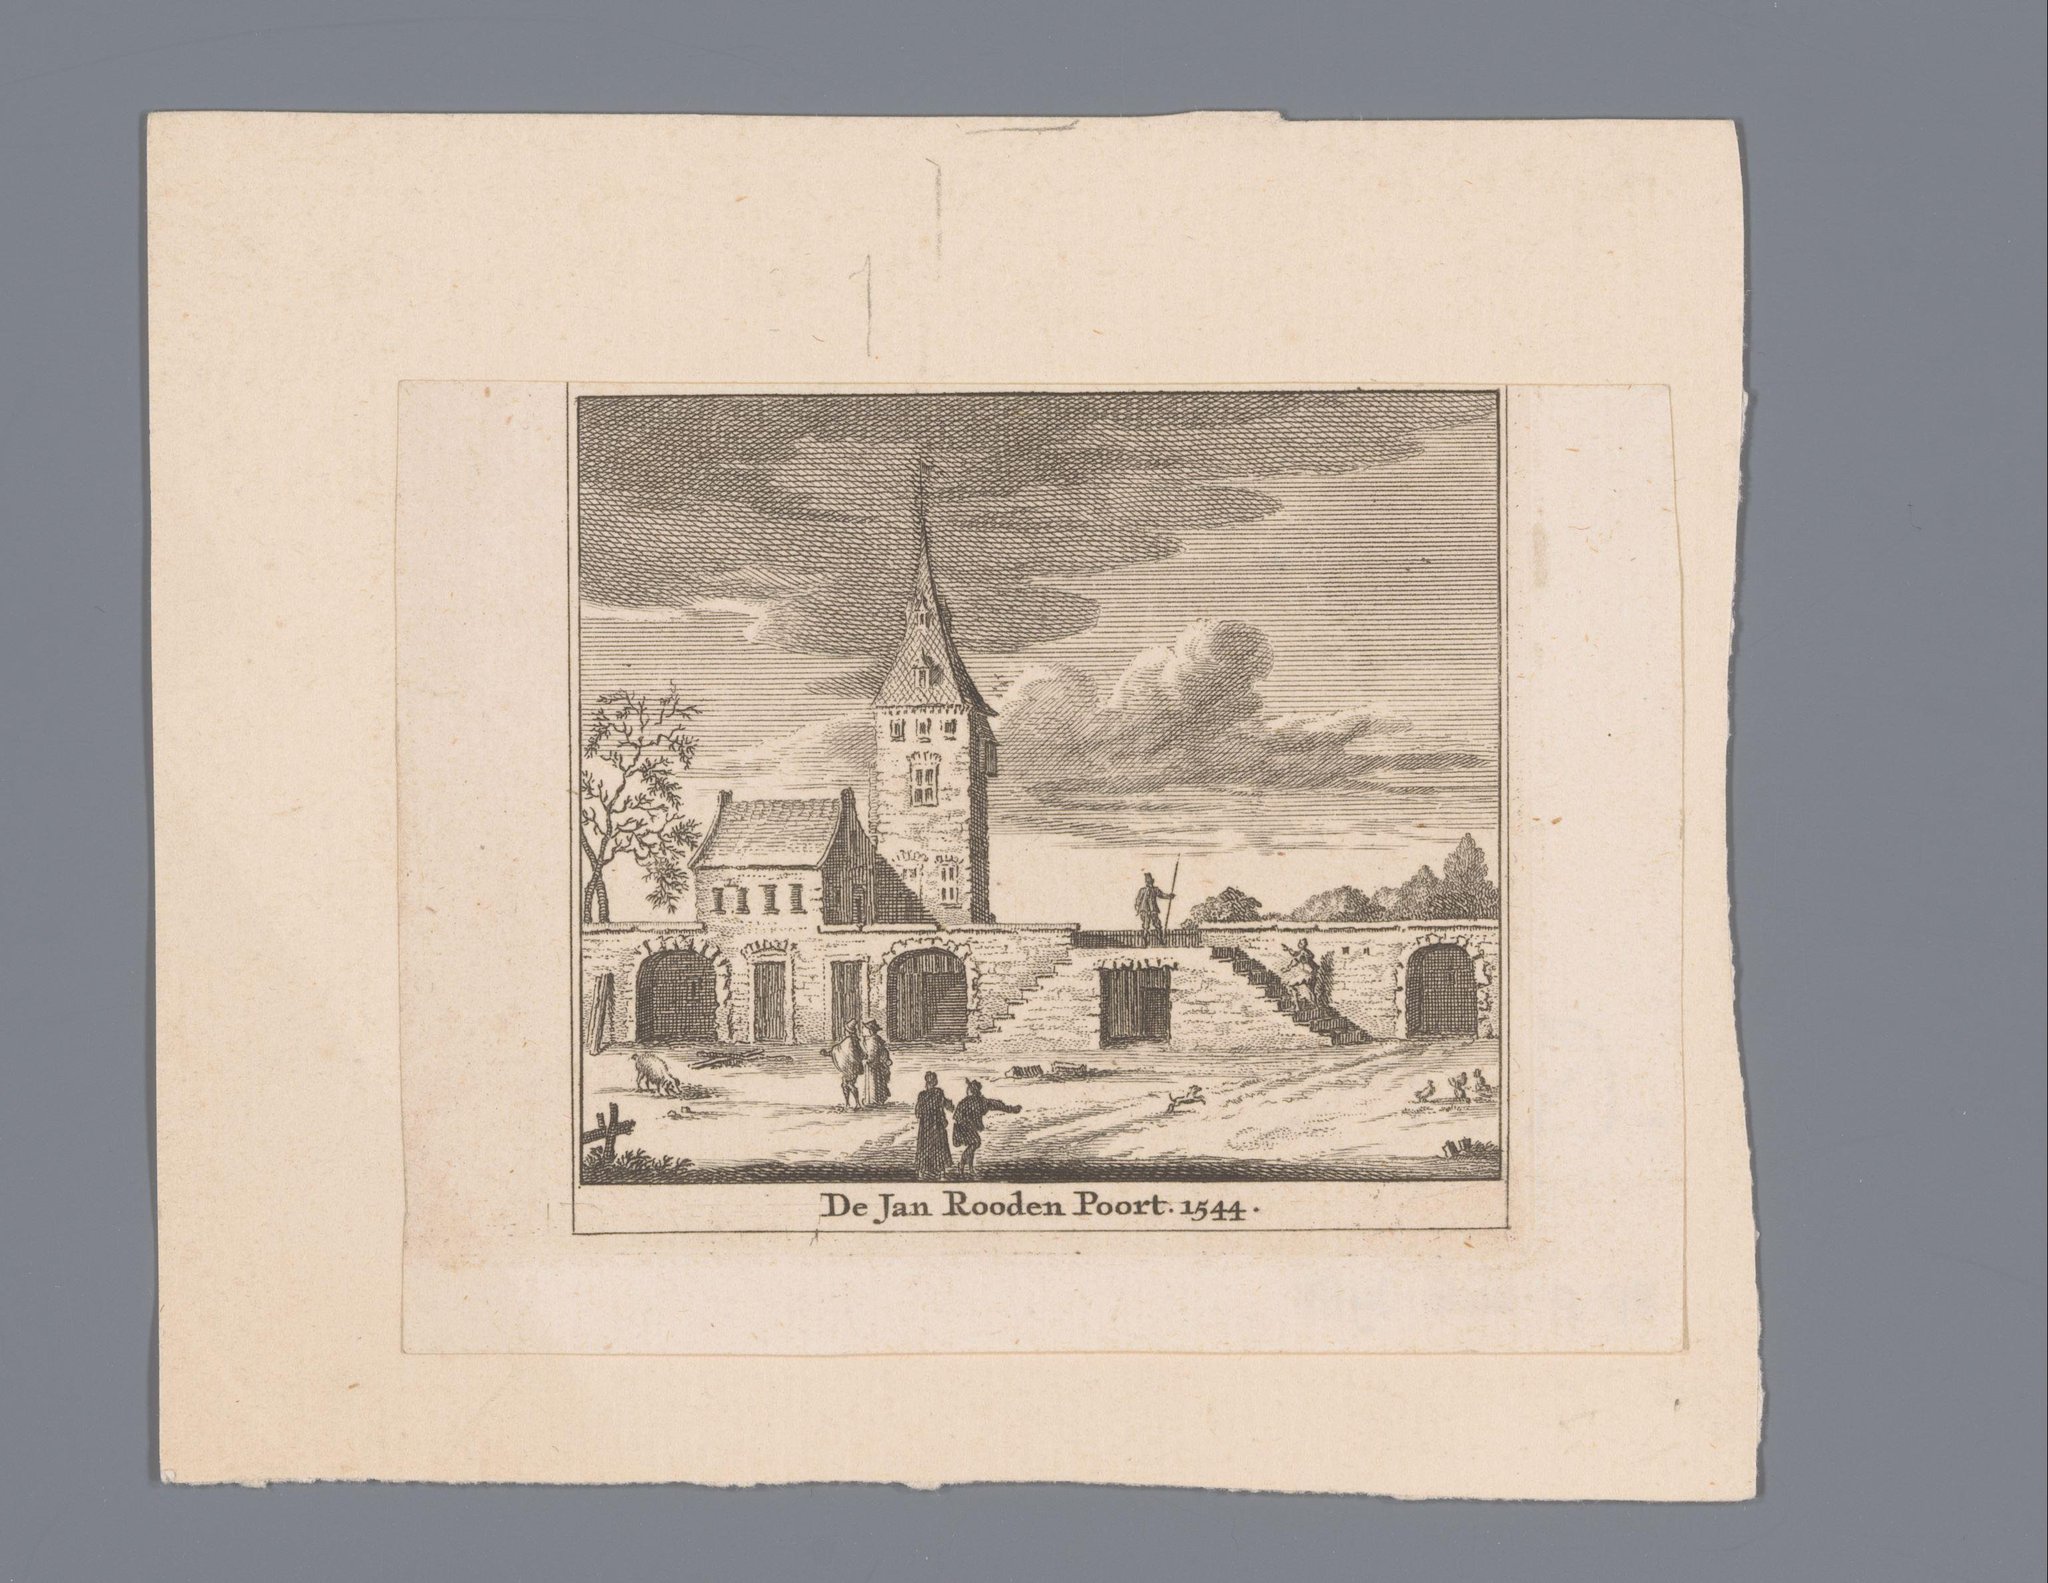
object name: print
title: Stadsmuur bij de Jan Roodenpoortstoren in Amsterdam, gezien van de stadszijde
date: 1723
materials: paper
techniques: engraving, etching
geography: amsterdam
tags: bridge in city across river, canal, etc.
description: Prent uit: Willink, Daniël. Amsterdamsch buitensingel, nevens omleggende dorpen (...). Amsterdam: Andries van Damme, 1723, tussen p. 34-35.